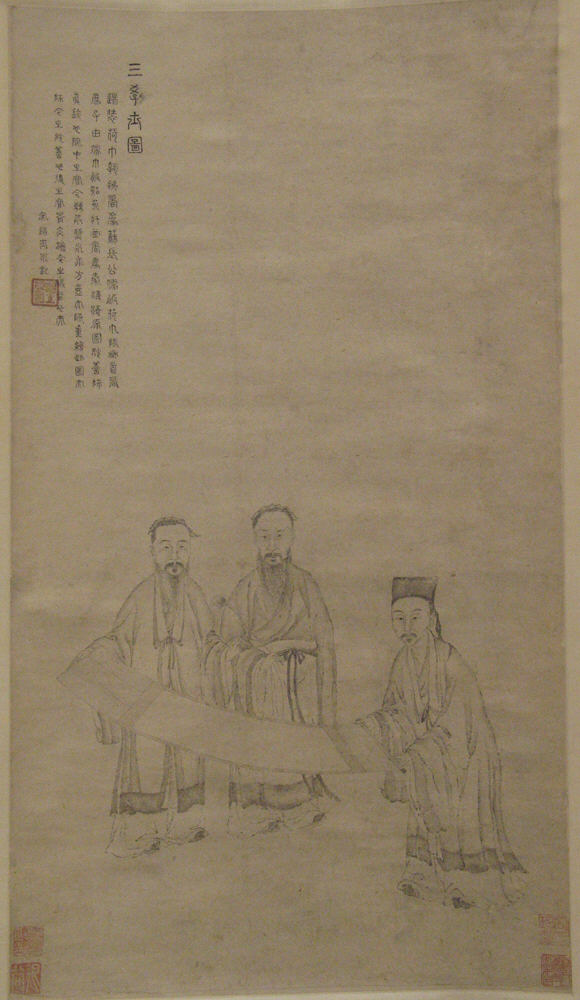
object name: hanging scroll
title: The Three Scholars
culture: chinese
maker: unidentified artist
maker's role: artist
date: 1644-1911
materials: ink, paper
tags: men